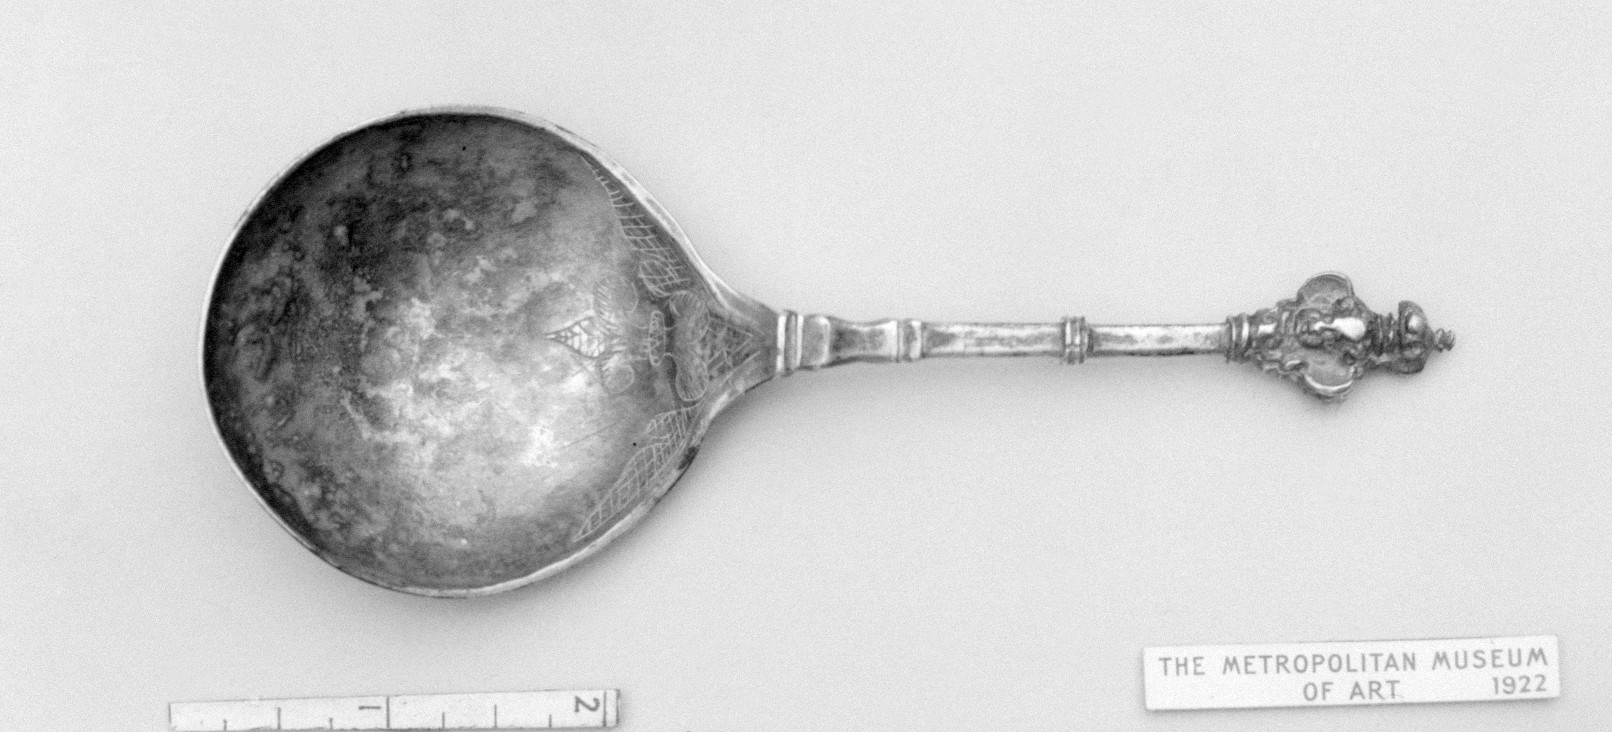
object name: spoon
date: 1618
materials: silver